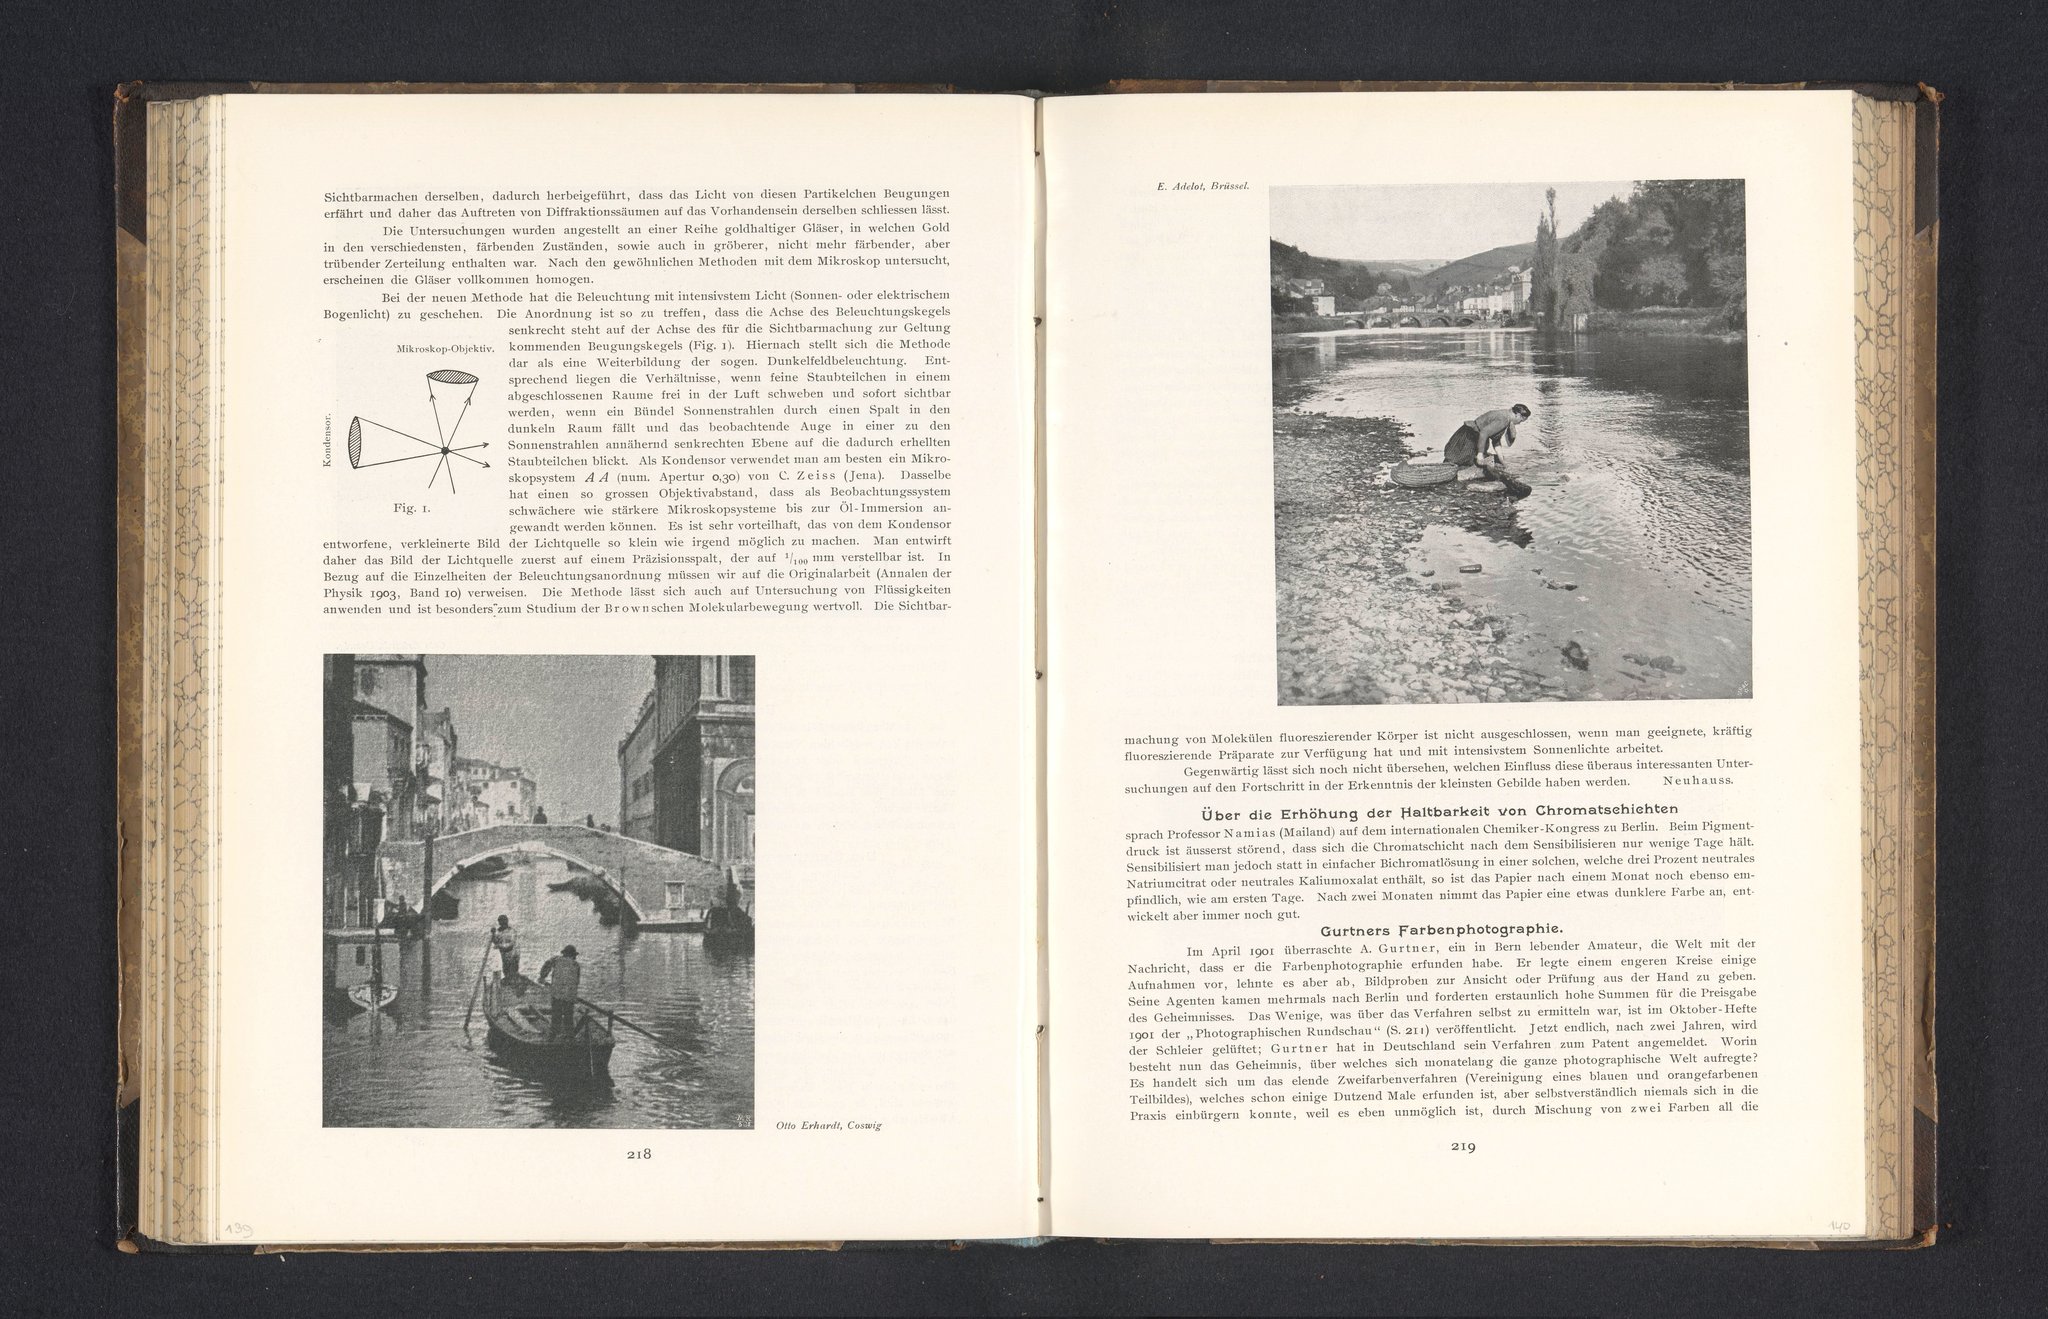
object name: photomechanical print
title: Vrouw wast kleding in een rivier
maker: edouard adelot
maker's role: fotograaf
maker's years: 1871-1937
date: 1898-1903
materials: paper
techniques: autotype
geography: berlin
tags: adult woman, river, laundering